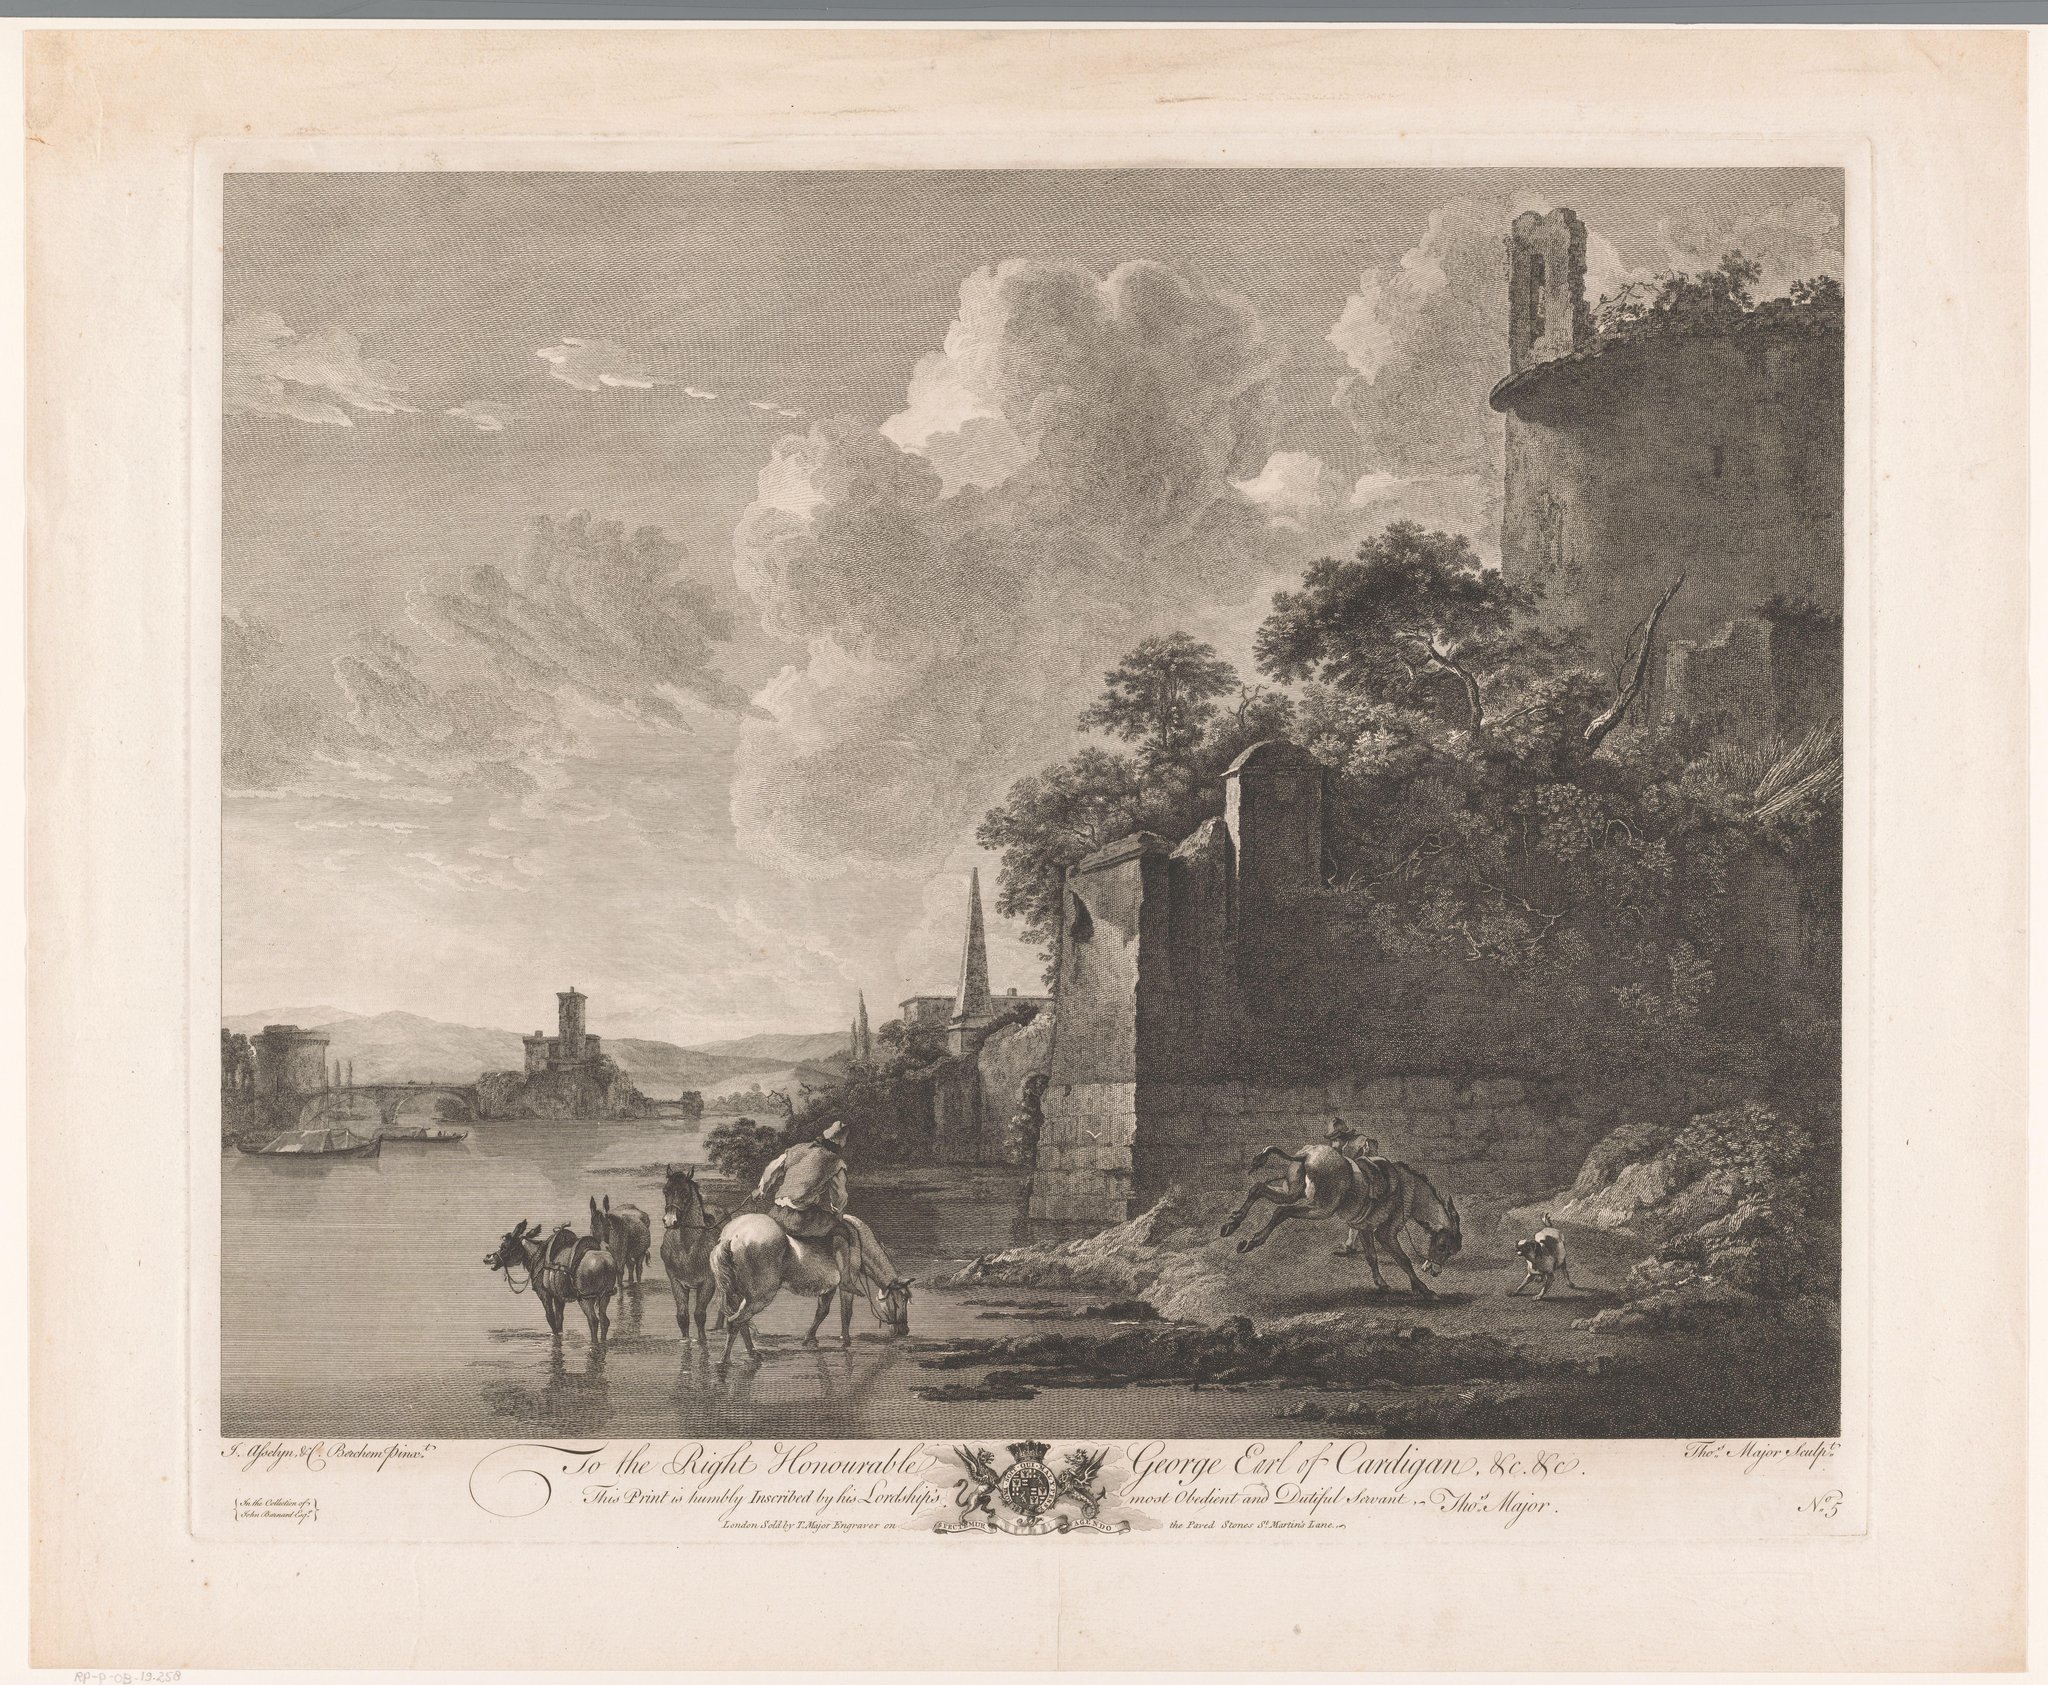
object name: print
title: Paarden en ezels aan de oever van een rivier bij een stad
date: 1724-1799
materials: paper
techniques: engraving, etching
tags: horses and kindred animals, low hill country (+ landscape with figures, staffage), river (+ landscape with figures, staffage)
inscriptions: collector's mark: Lugt 240, collector's mark: Lugt 2228